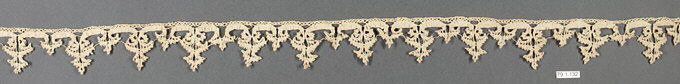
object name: strip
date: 1550-1600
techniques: lace